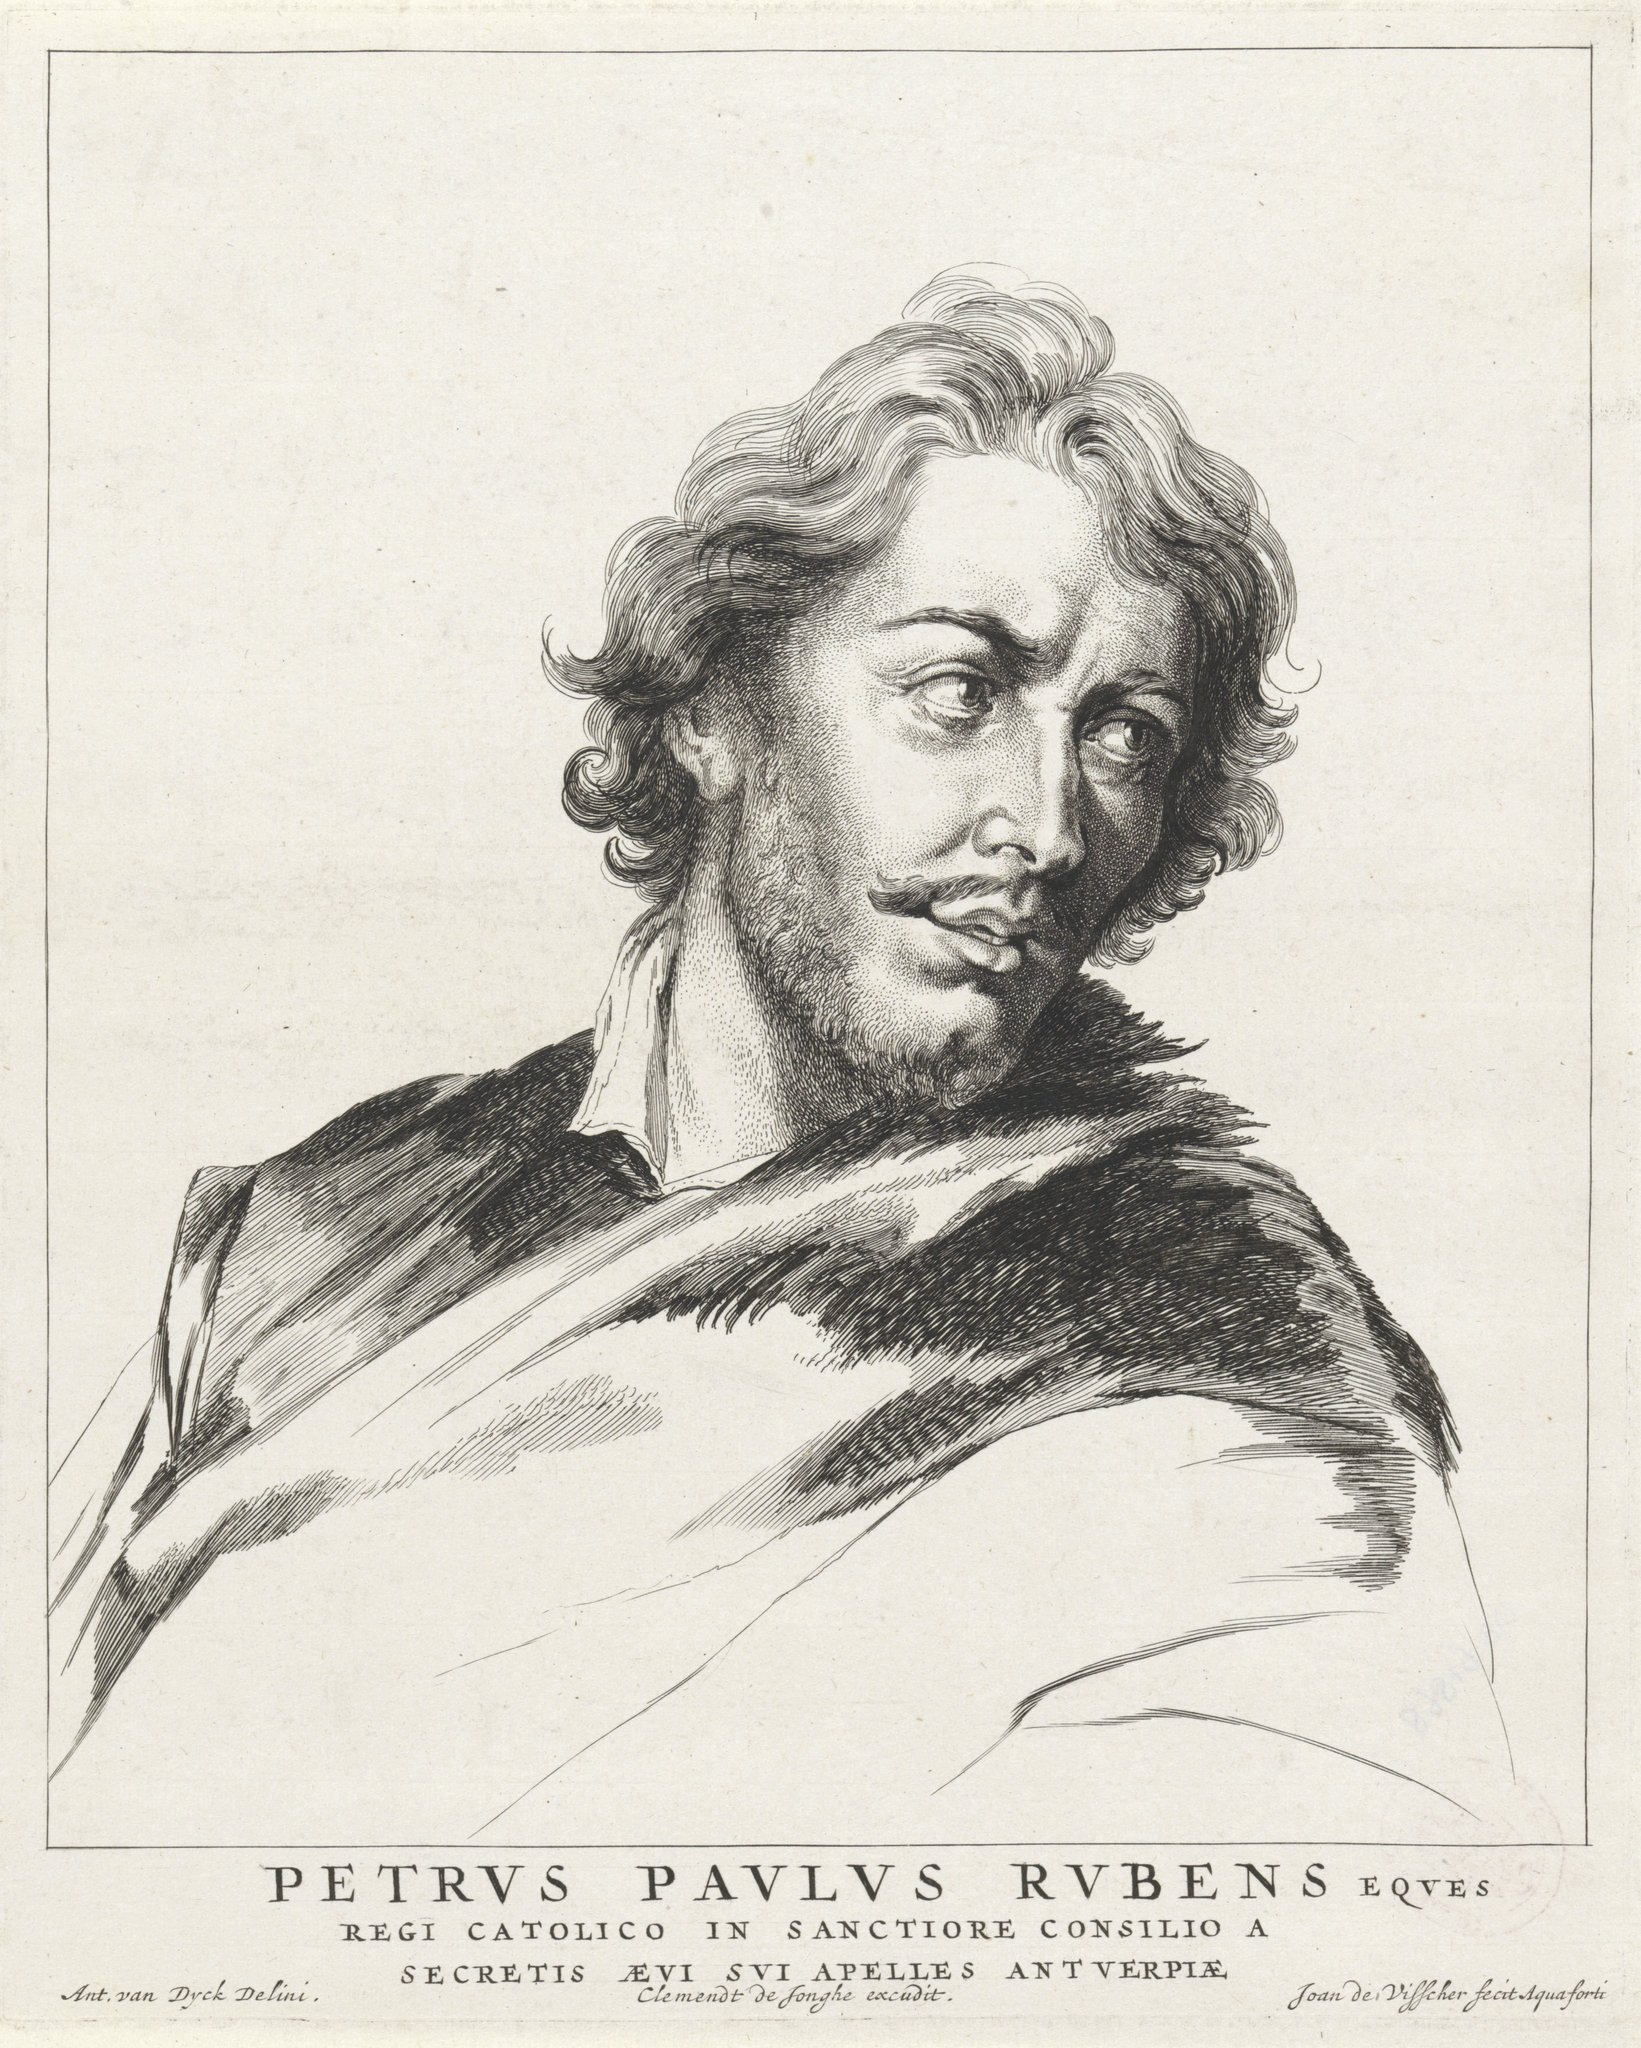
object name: print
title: Portret van Peter Paul Rubens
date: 1643-1670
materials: paper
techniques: engraving, etching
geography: amsterdam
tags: antwerp, painter, print maker, draughtsman, peter paul rubens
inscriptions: collector's mark: Lugt 240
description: Portret van een man, mogelijk de Vlaamse kunstenaar en diplomaat Peter Paul Rubens.